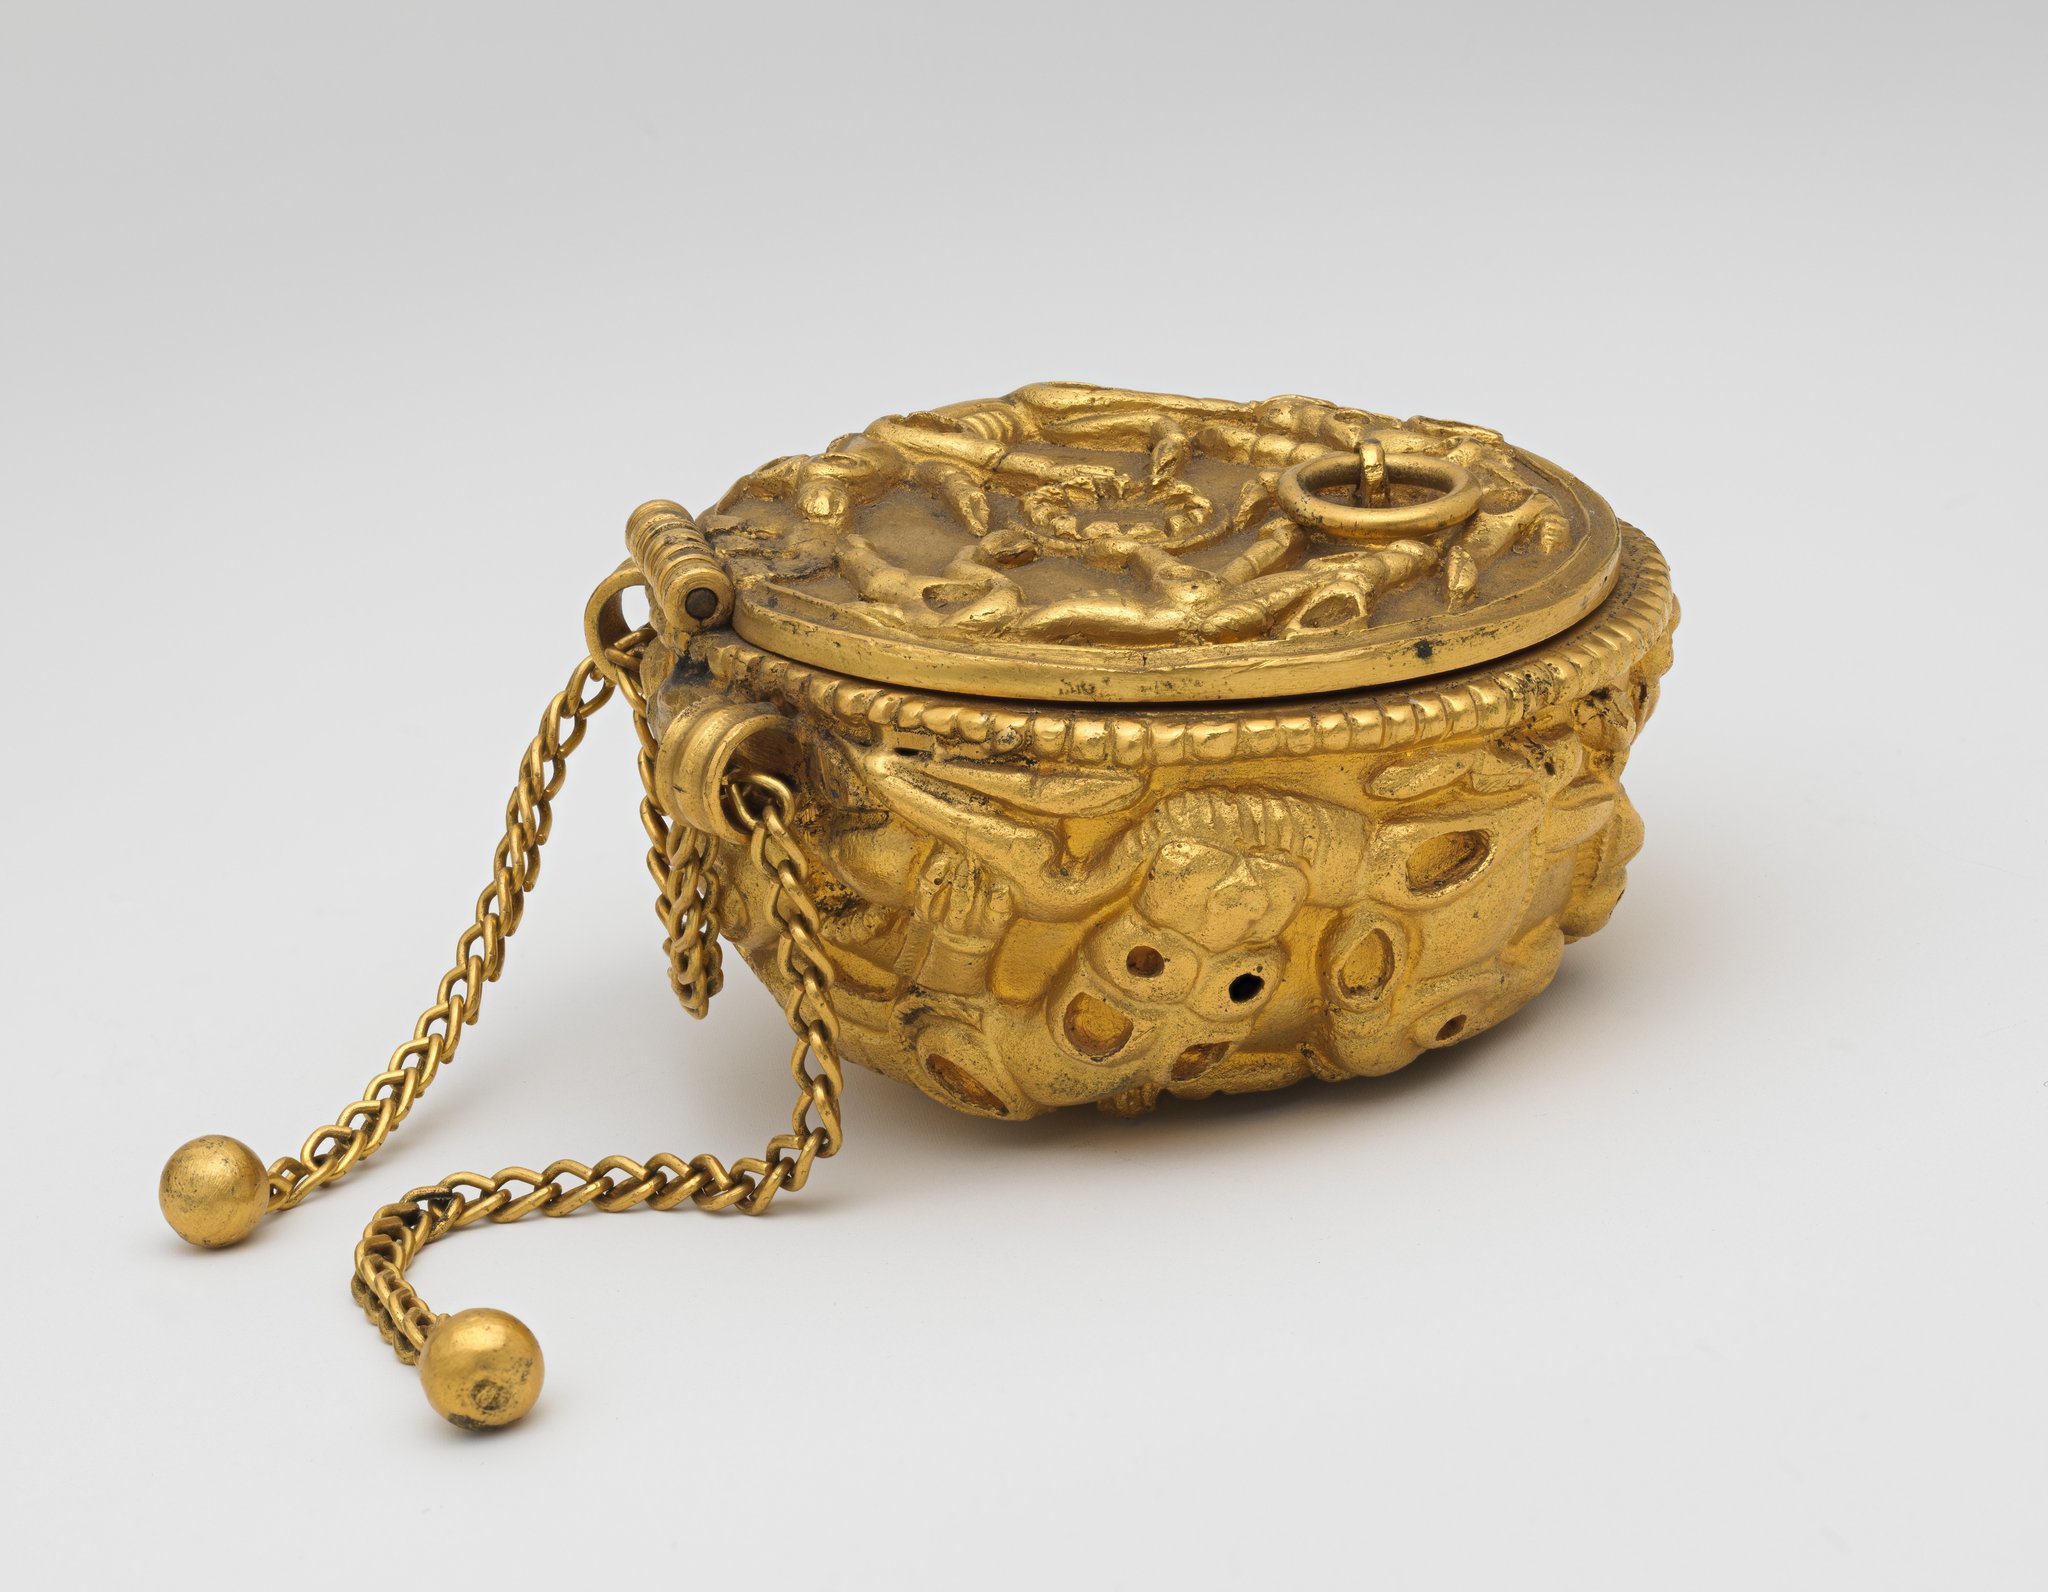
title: Reproduction of a Sarmatian box and lid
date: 1801-1900